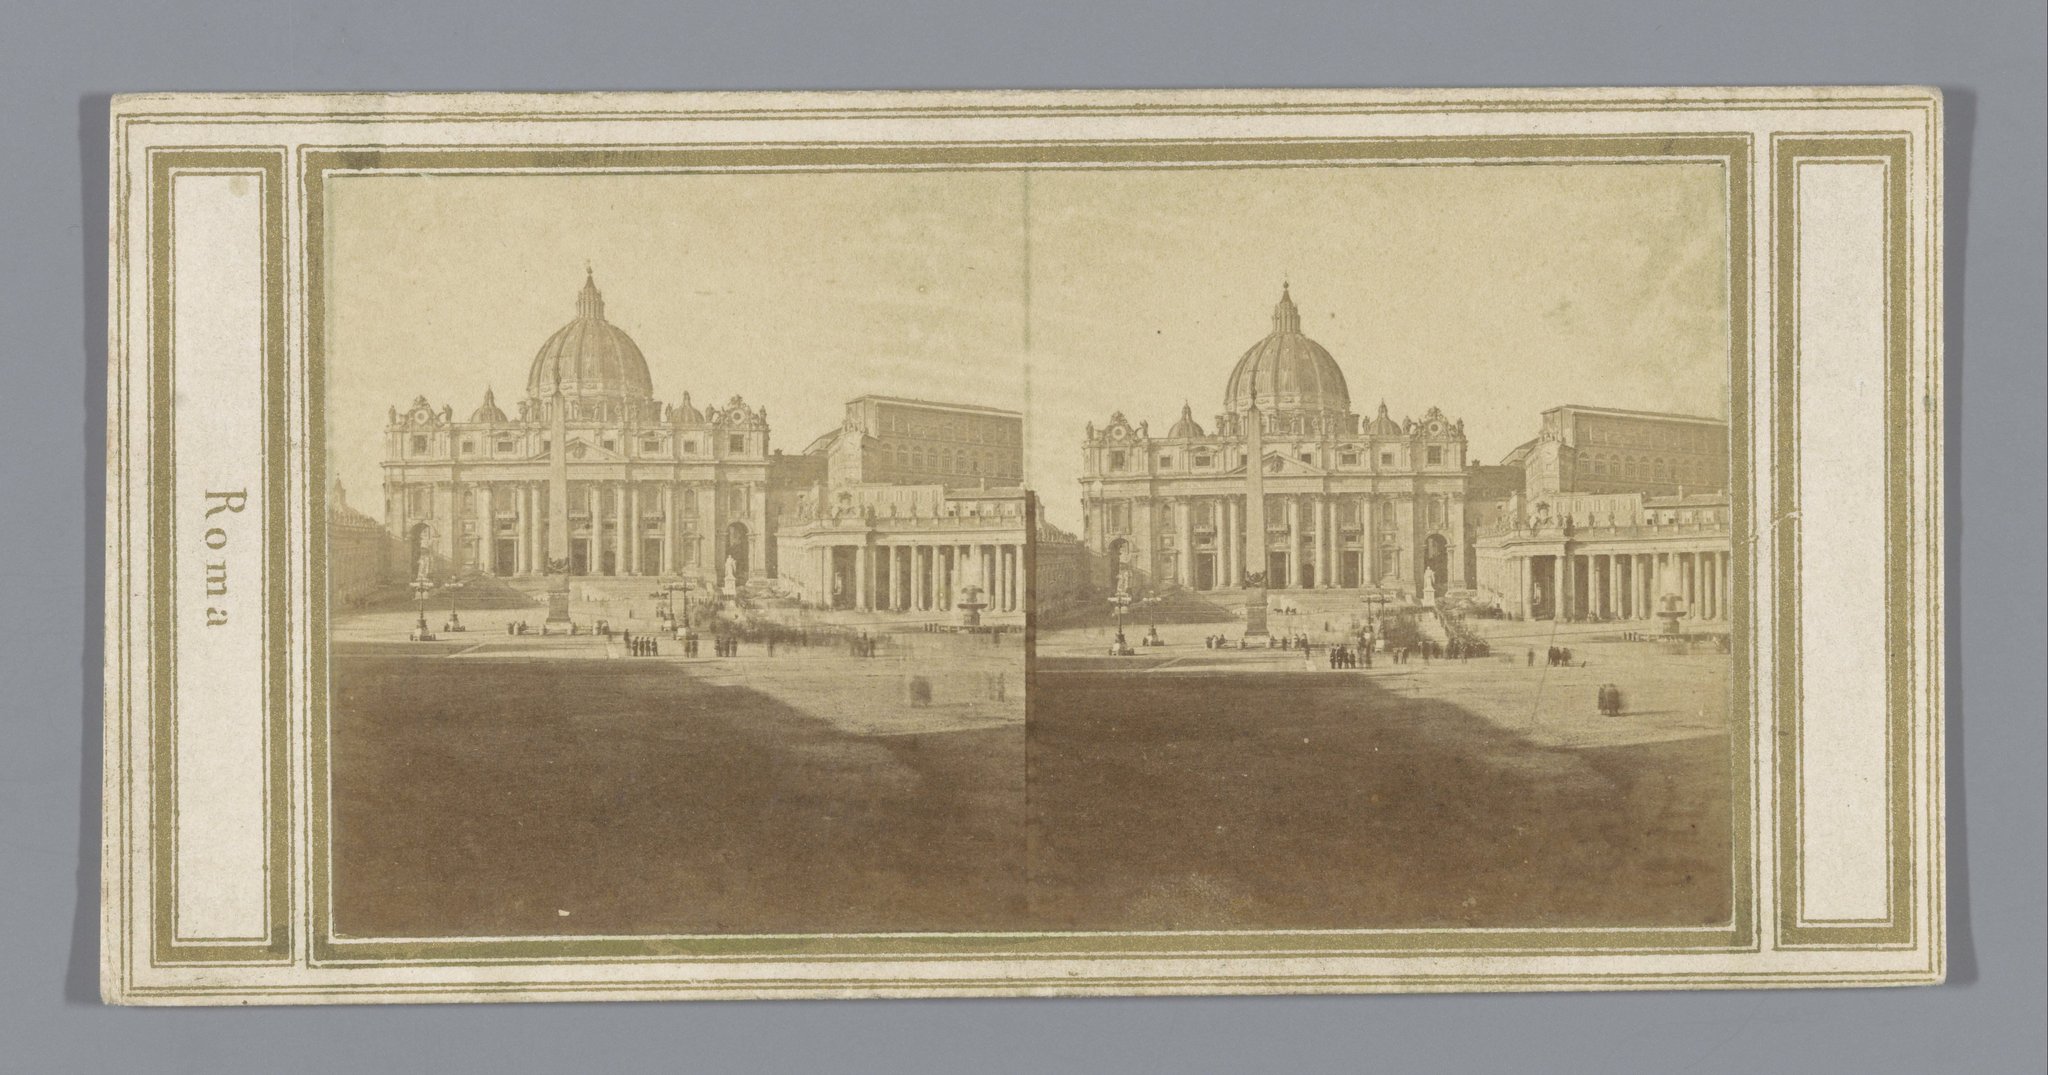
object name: stereograph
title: Gezicht op het Sint-Pieterplein te Vaticaanstad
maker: Anonymous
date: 1855-1860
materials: cardboard, photographic support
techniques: albumen print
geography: sint-pietersplein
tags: square, place, circus, etc., church (exterior)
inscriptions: number: ‘H. 3.’